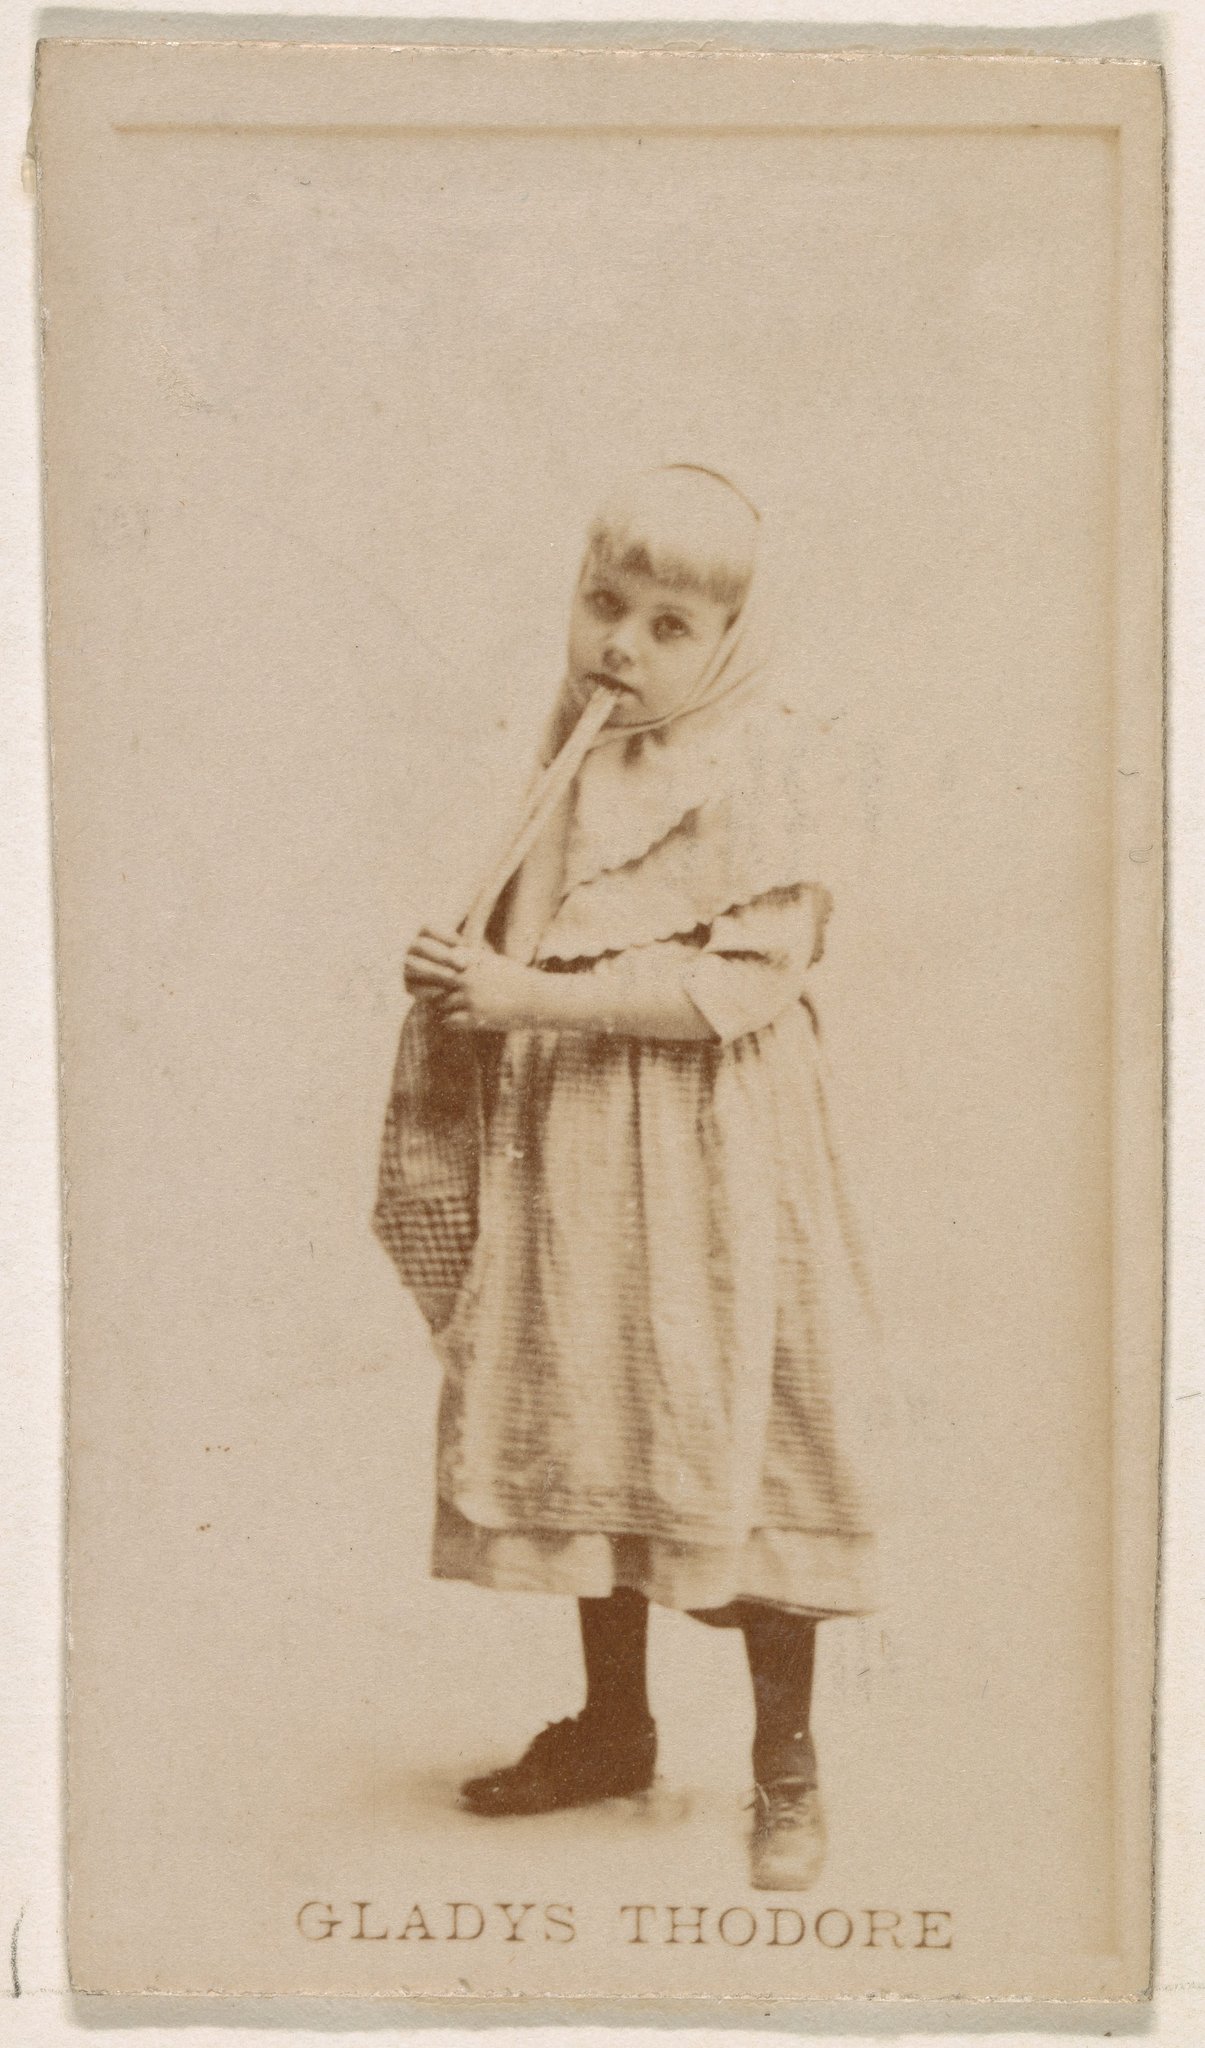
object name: photograph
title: Gladys Thodore, from the Actresses series (N245) issued by Kinney Brothers to promote Sweet Caporal Cigarettes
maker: kinney brothers tobacco company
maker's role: publisher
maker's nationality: american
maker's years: 1869-2011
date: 1890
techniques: albumen silver print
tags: girls,portraits,actresses